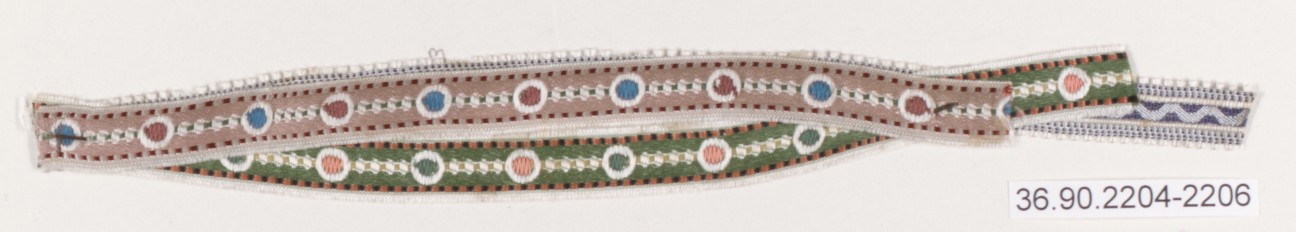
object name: piece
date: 1801-1900